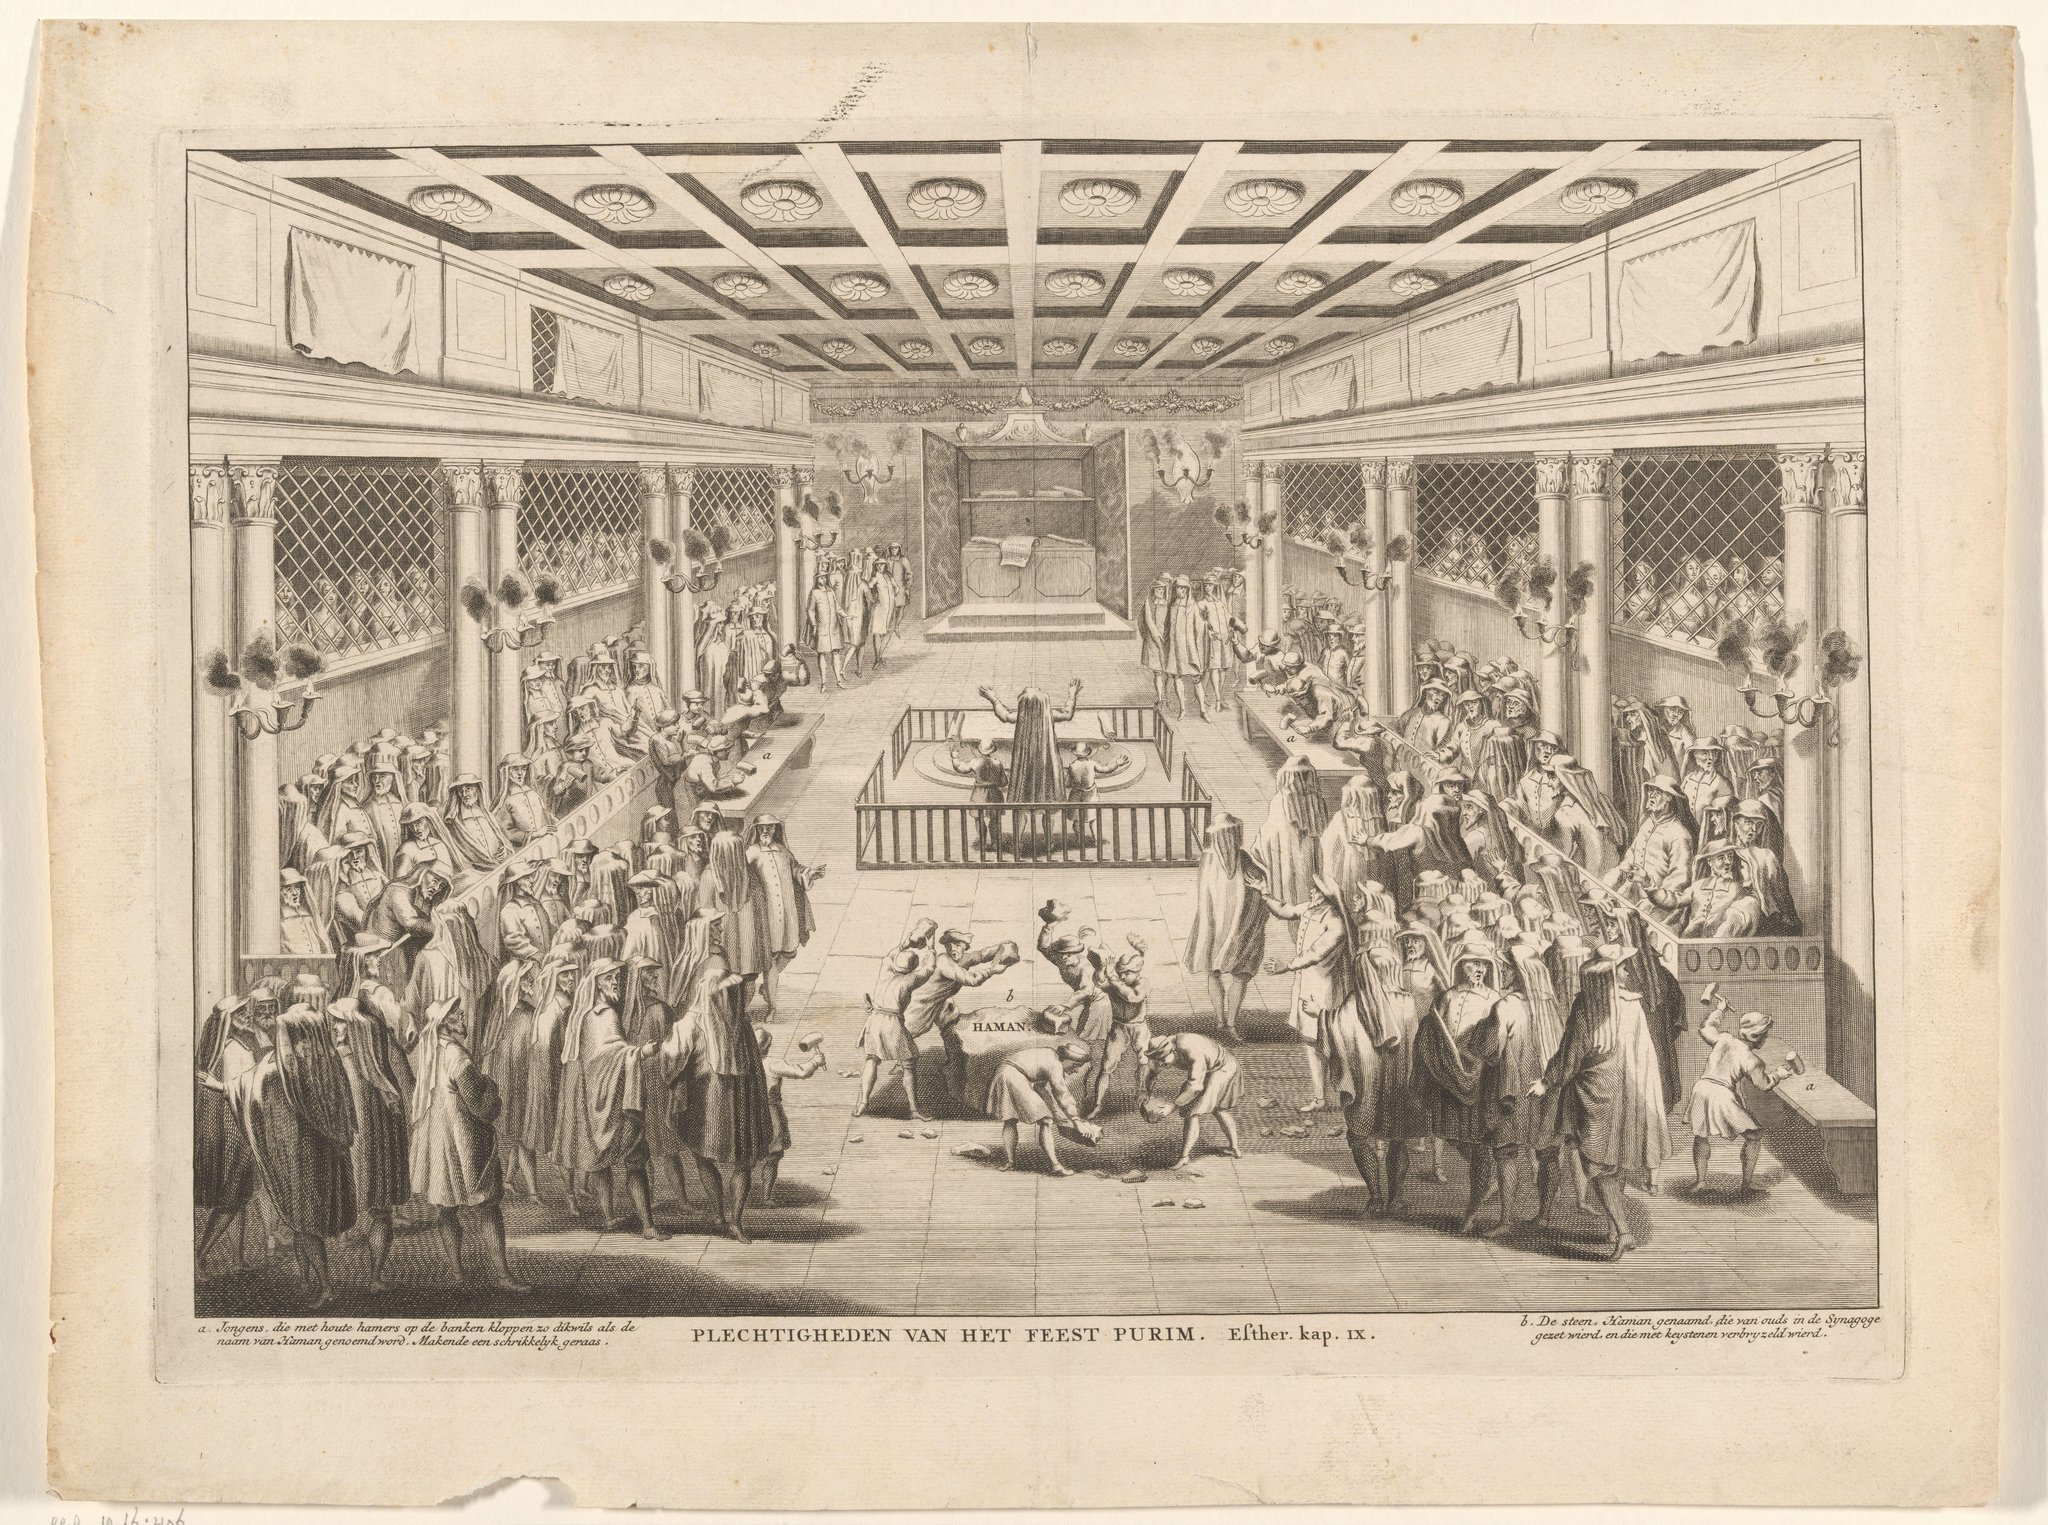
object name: book illustration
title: Plechtigheden van het feest Purim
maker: Anonymous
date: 1731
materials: paper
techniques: engraving, etching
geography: netherlands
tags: 'purim', feast of lots, making noise during the 'purim'-service (with rattles, 'hamandreher', grogger, whenever the name of haman is pronounced, 'hamanklopfen')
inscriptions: collector's mark: Lugt 2228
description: Illustratie uit: Augustin Calmet, Byvoegzel tot het algemeen groot historisch, oordeelkundig, chronologisch, geografisch, en letterlyk naam- en woord-boek, van den gantschen H. Bijbel. Versiert met nodige Prentverbeeldingen en kopere Platen, diendende tot de Gedenkstukken der Jooden en andere Oudheden, ter Opheldering der H. Schrift (...), deel 1, Amsterdam: R. en J. Wetstein en W. Smith; Leiden: S. Luchtmans, 1731 (In de eerdere delen uit 1725 en 1727 komt deze illustratie niet voor).